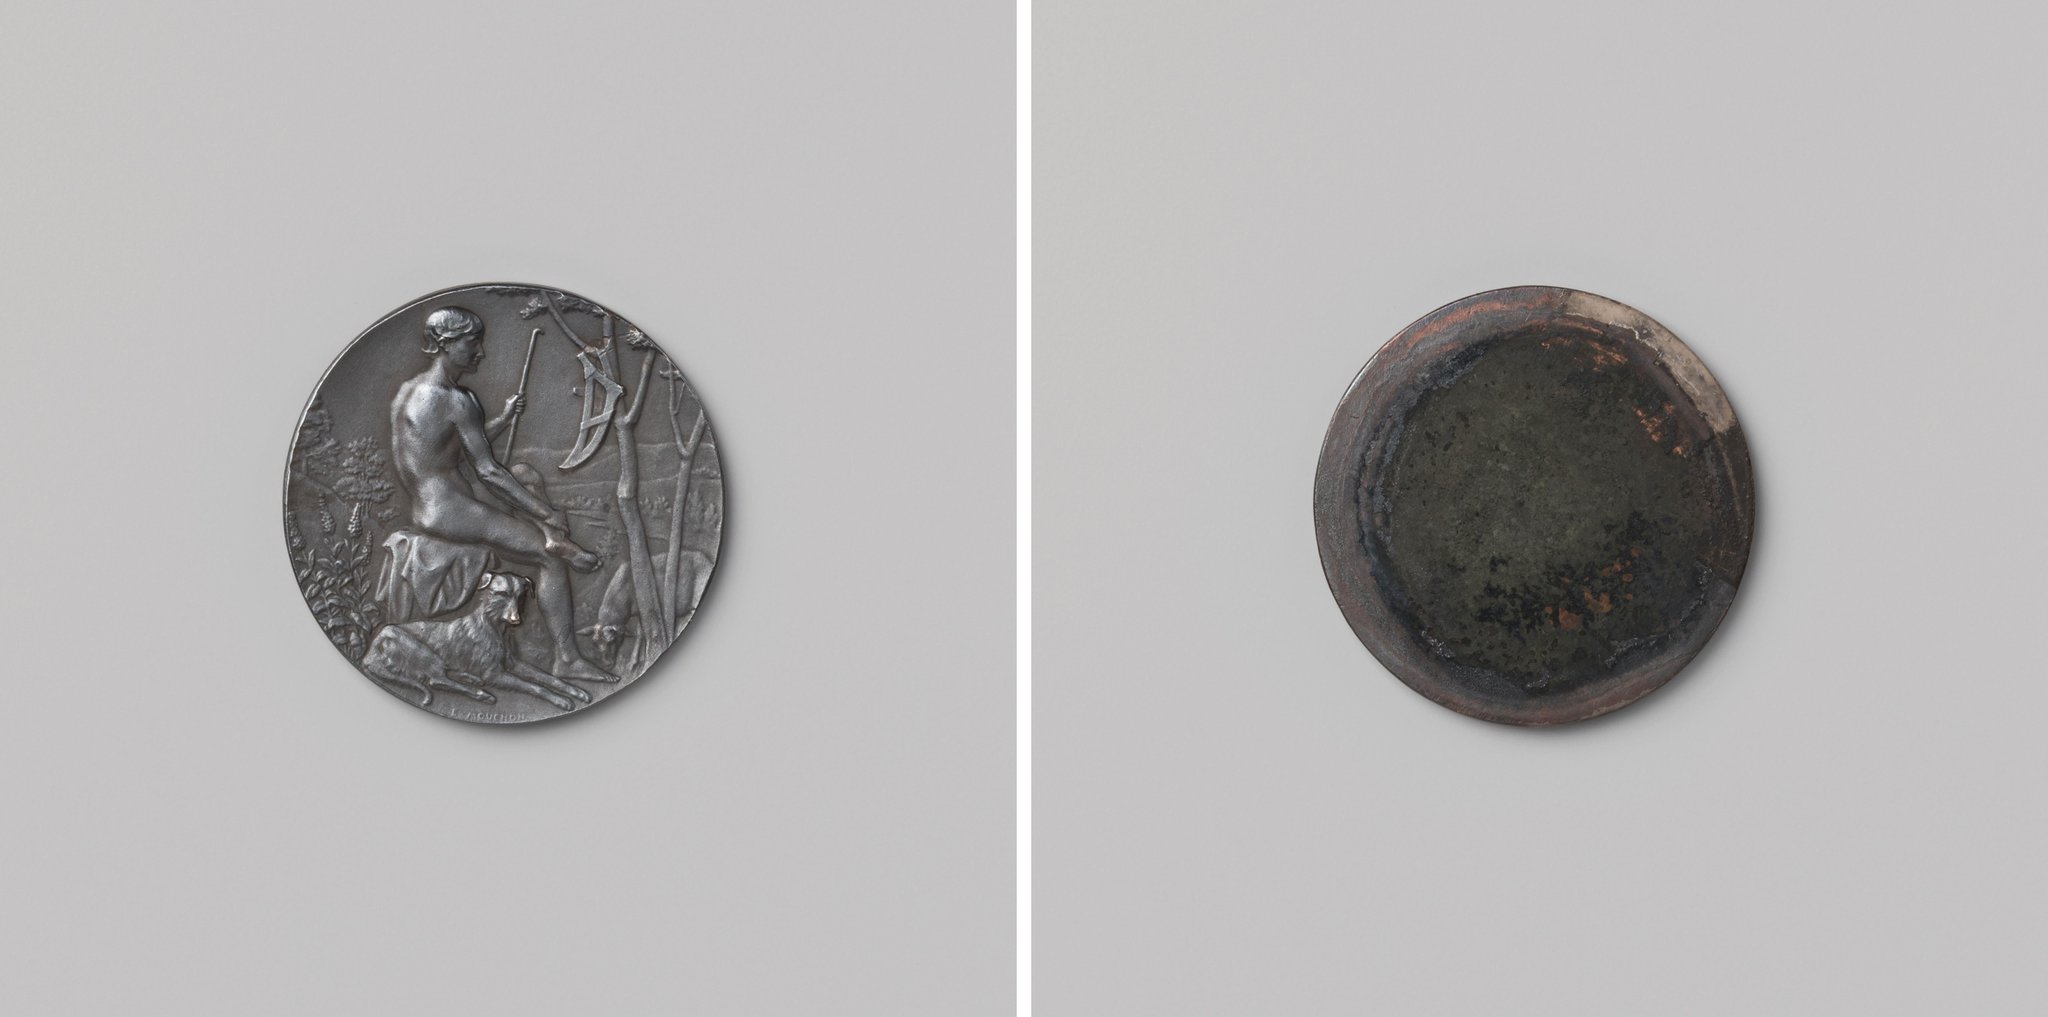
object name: medal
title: jonge herder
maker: louis eugène mouchon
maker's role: medailleur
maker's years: 1843-1914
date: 1889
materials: silver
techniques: casting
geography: paris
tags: herding, herdsman, herdswoman, shepherd, shepherdess, cowherd, etc.